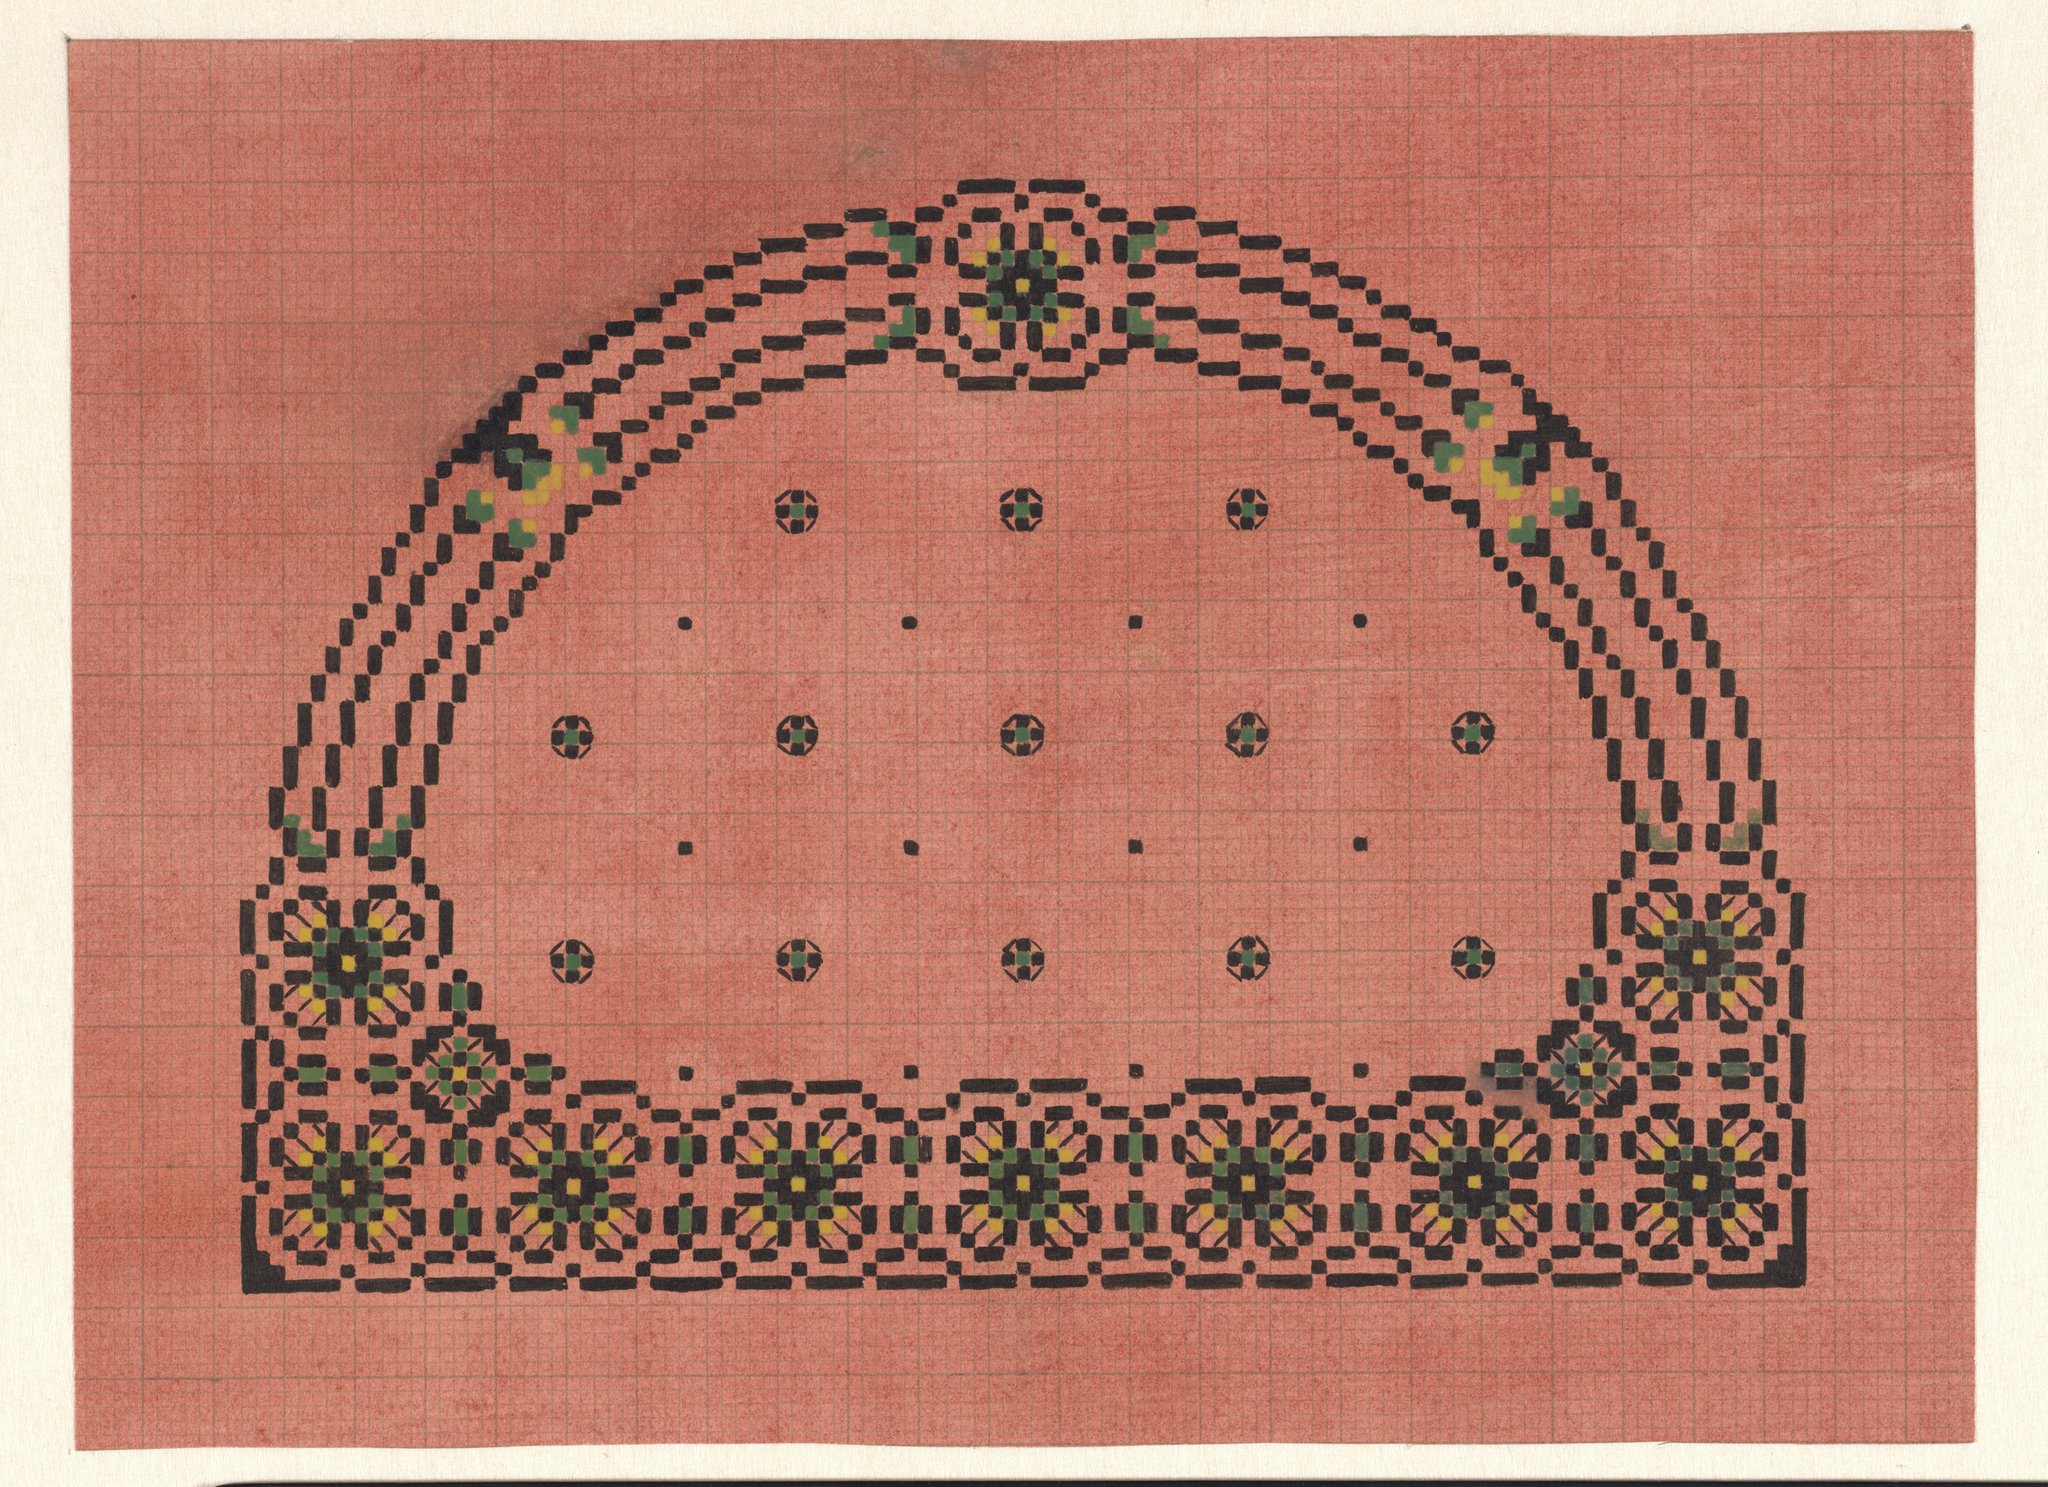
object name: drawing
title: Ontwerp voor het borduurwerk op een theemuts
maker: johanna quirina van regteren altena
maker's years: 1876-1954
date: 1886-1954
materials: paper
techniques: brush